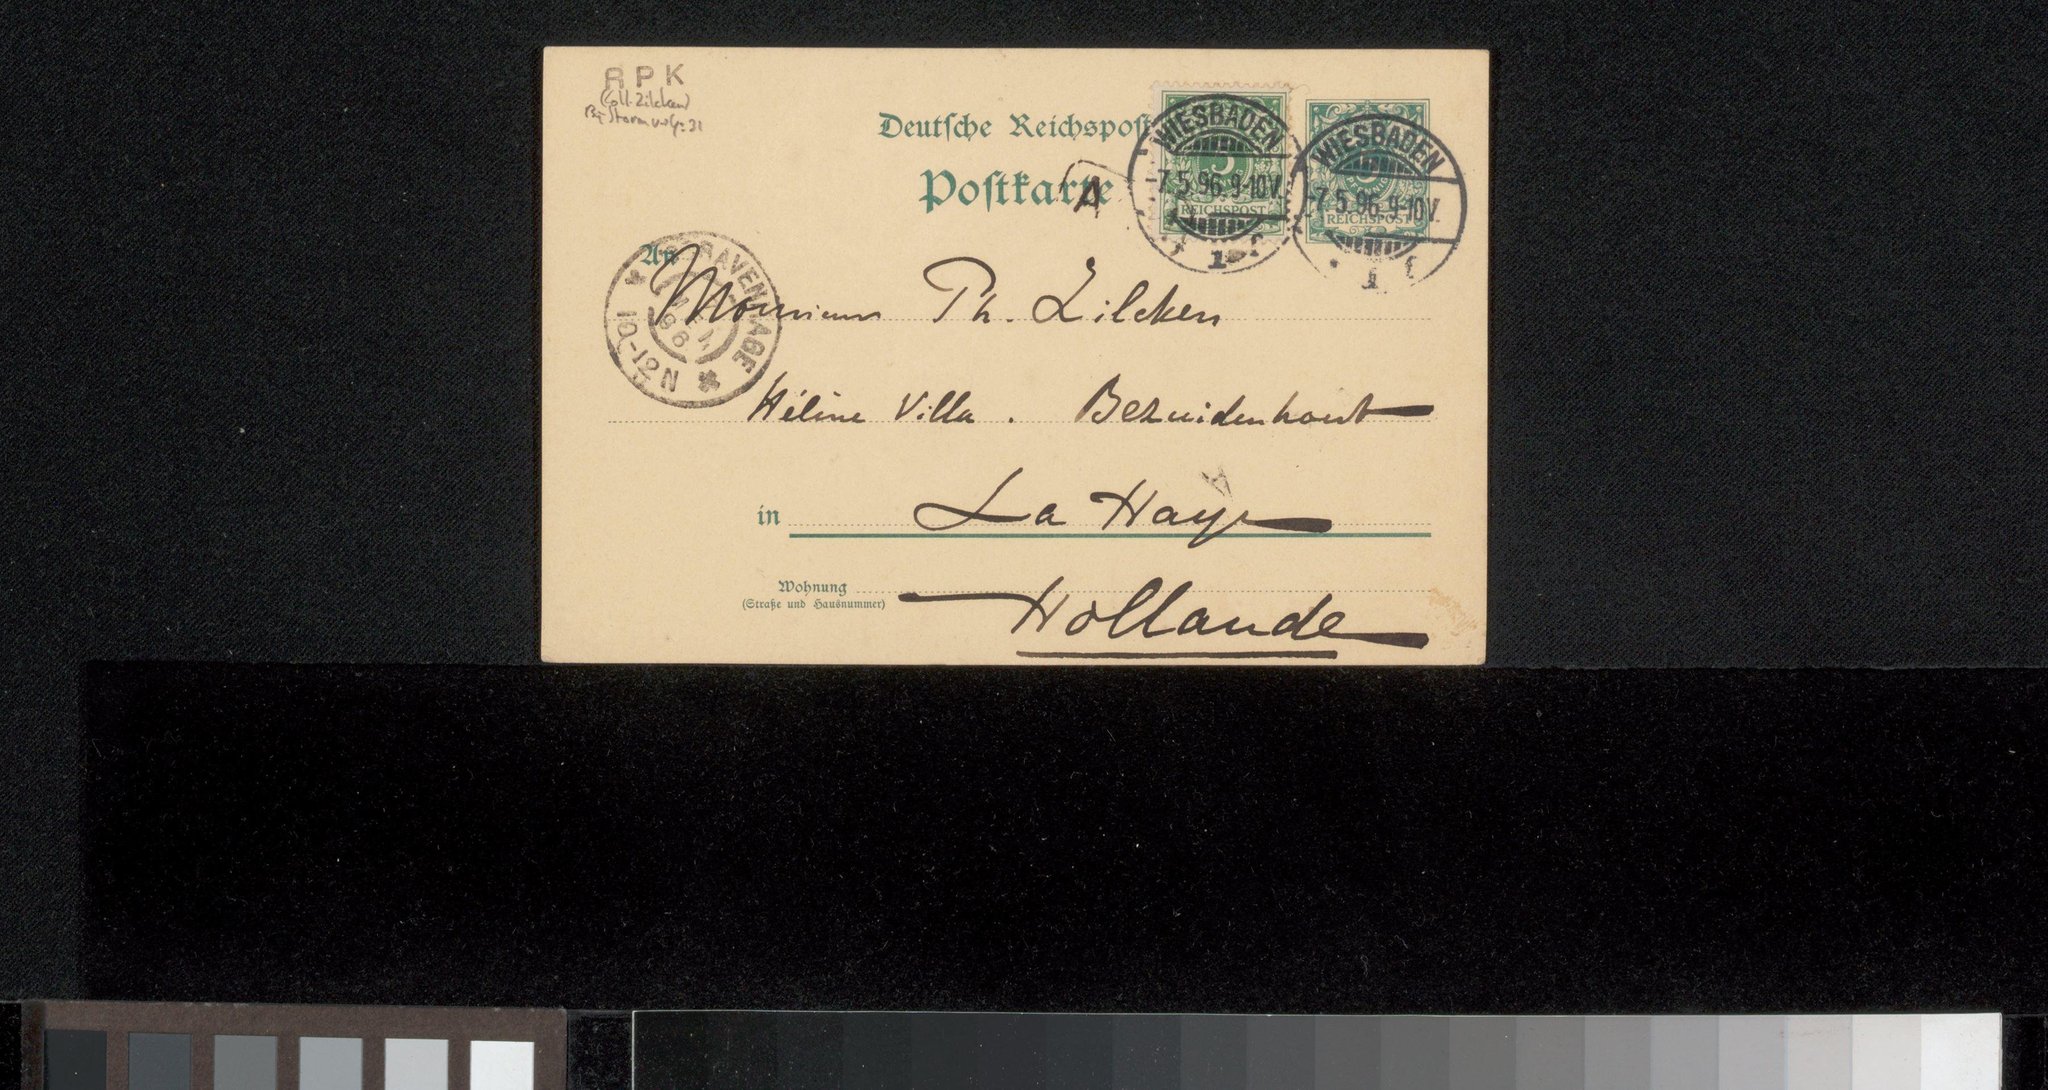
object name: postcard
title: Briefkaart aan Philip Zilcken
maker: carel nicolaas storm van s-gravesande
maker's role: draughtsman, print maker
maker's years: 1841-1924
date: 1896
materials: cardboard, ink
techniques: pen, writing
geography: wiesbaden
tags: rotterdam, amsterdam, print maker, george hendrik breitner, the hague, painter, draughtsman, philip zilcken, the graphic arts, illustration ~ printed matter, book, printed matter, vienna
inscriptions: collector's mark: ‘RPK’